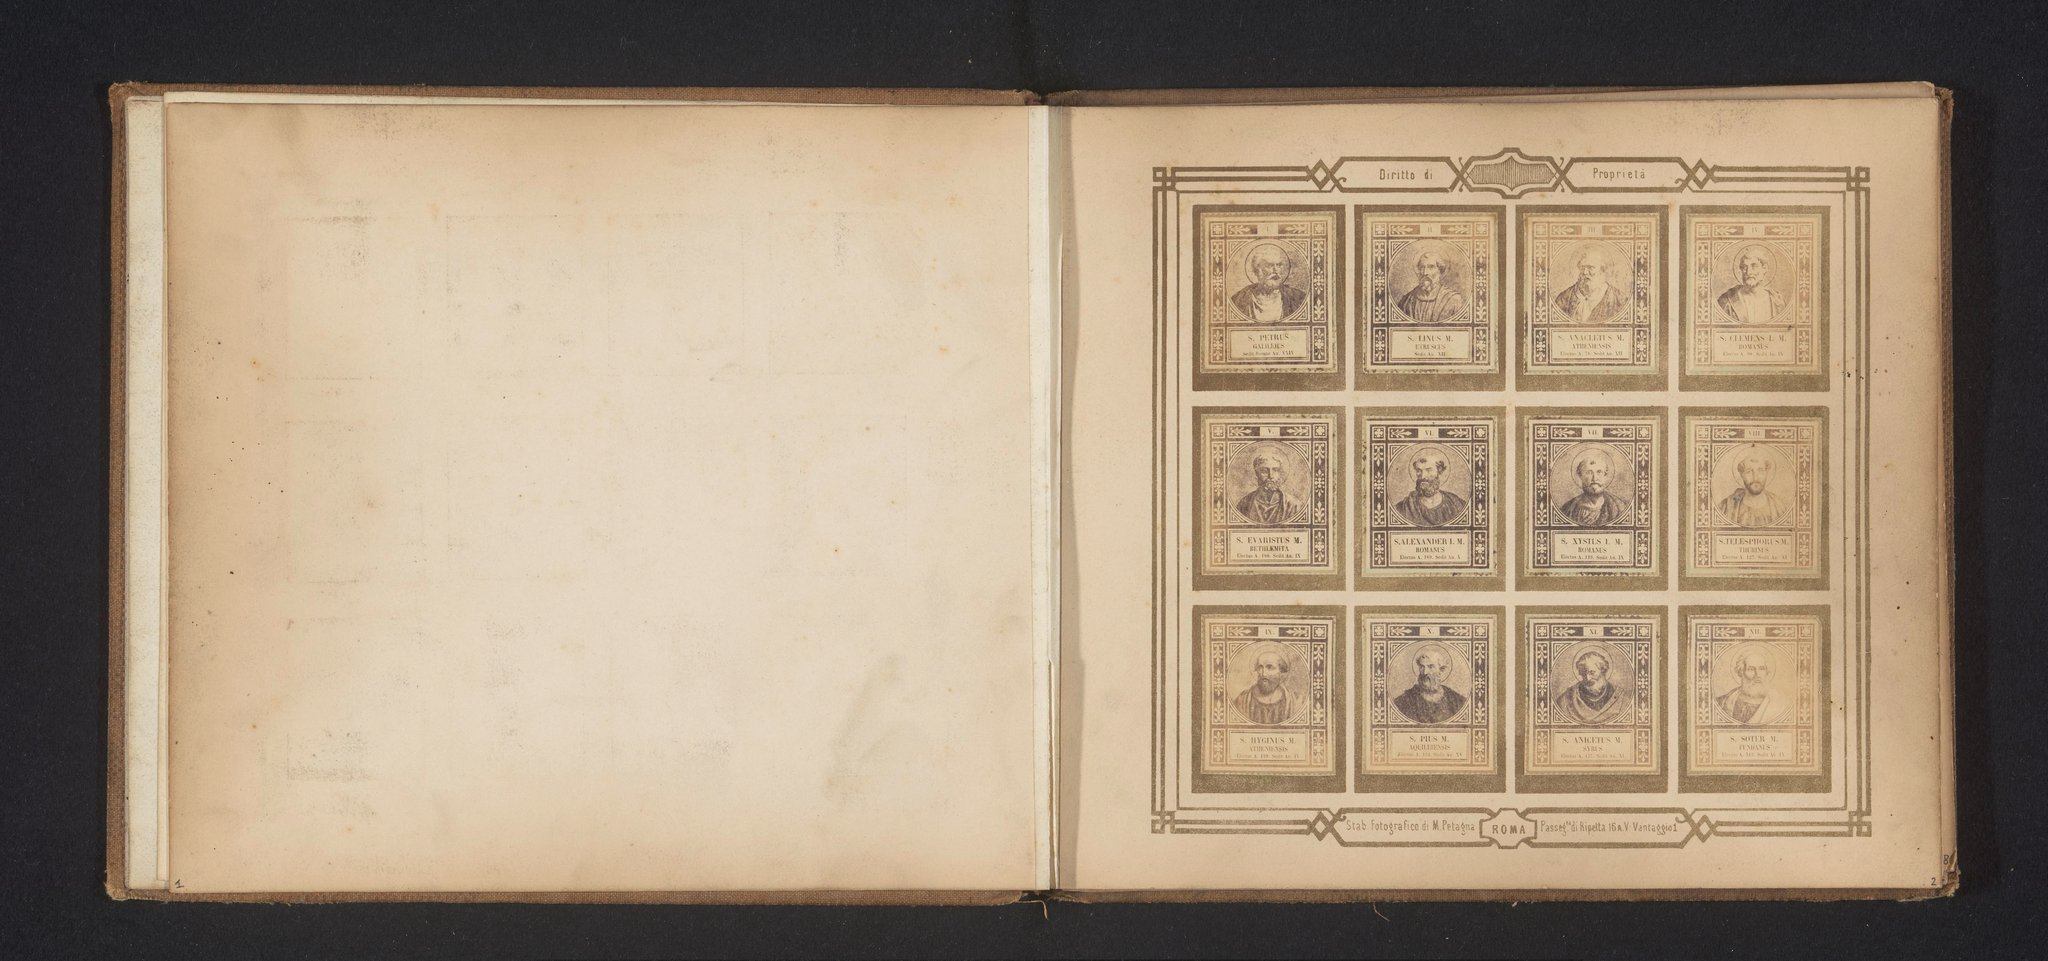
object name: page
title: Fotoreproductie van twaalf portretten van pausen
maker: m. petagna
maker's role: fotograaf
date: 1854-1864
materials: photographic support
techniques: albumen print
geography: rome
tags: pope